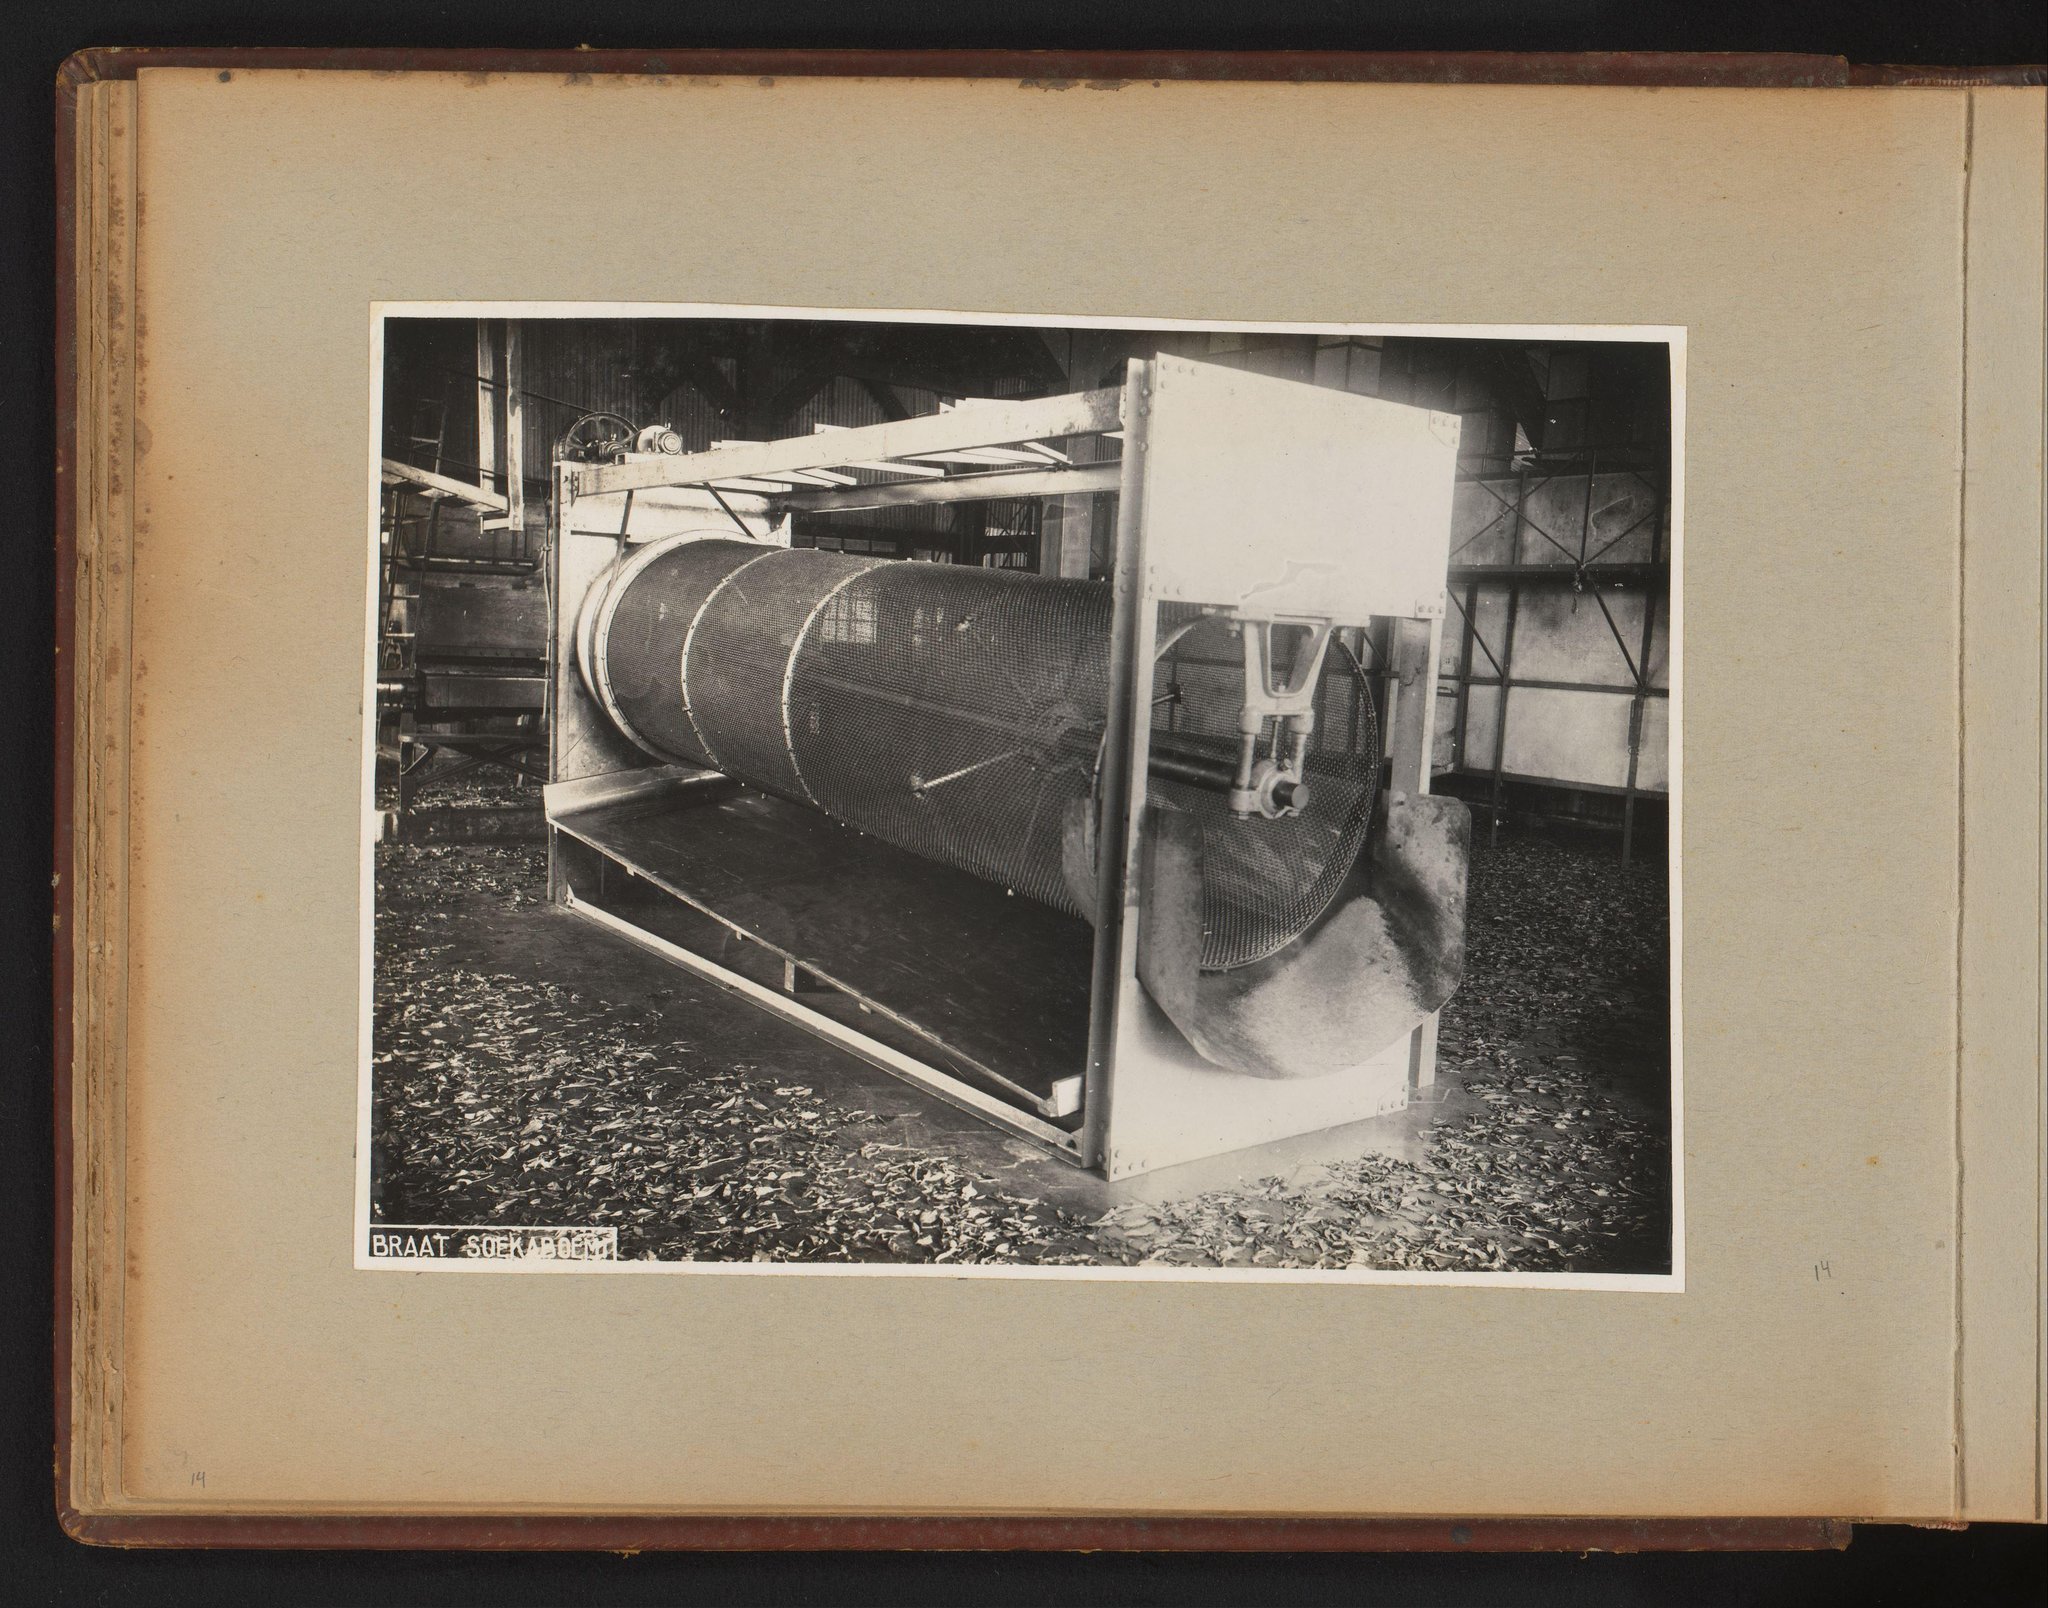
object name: album leaf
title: Trommel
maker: Anonymous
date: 1931-1937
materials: cardboard, photographic support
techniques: gelatin silver print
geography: soekaboemi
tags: factory-interior, machine shop, machines; parts of machines; tools and appliances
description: Albumblad met een foto van een trommel voor een machine. Onderdeel van een fotoalbum met foto's van machines en constructies van de N.V. Machinefabriek Braat te Soerabaja, Soekaboemi en Tegal uit de periode 1931-1937.